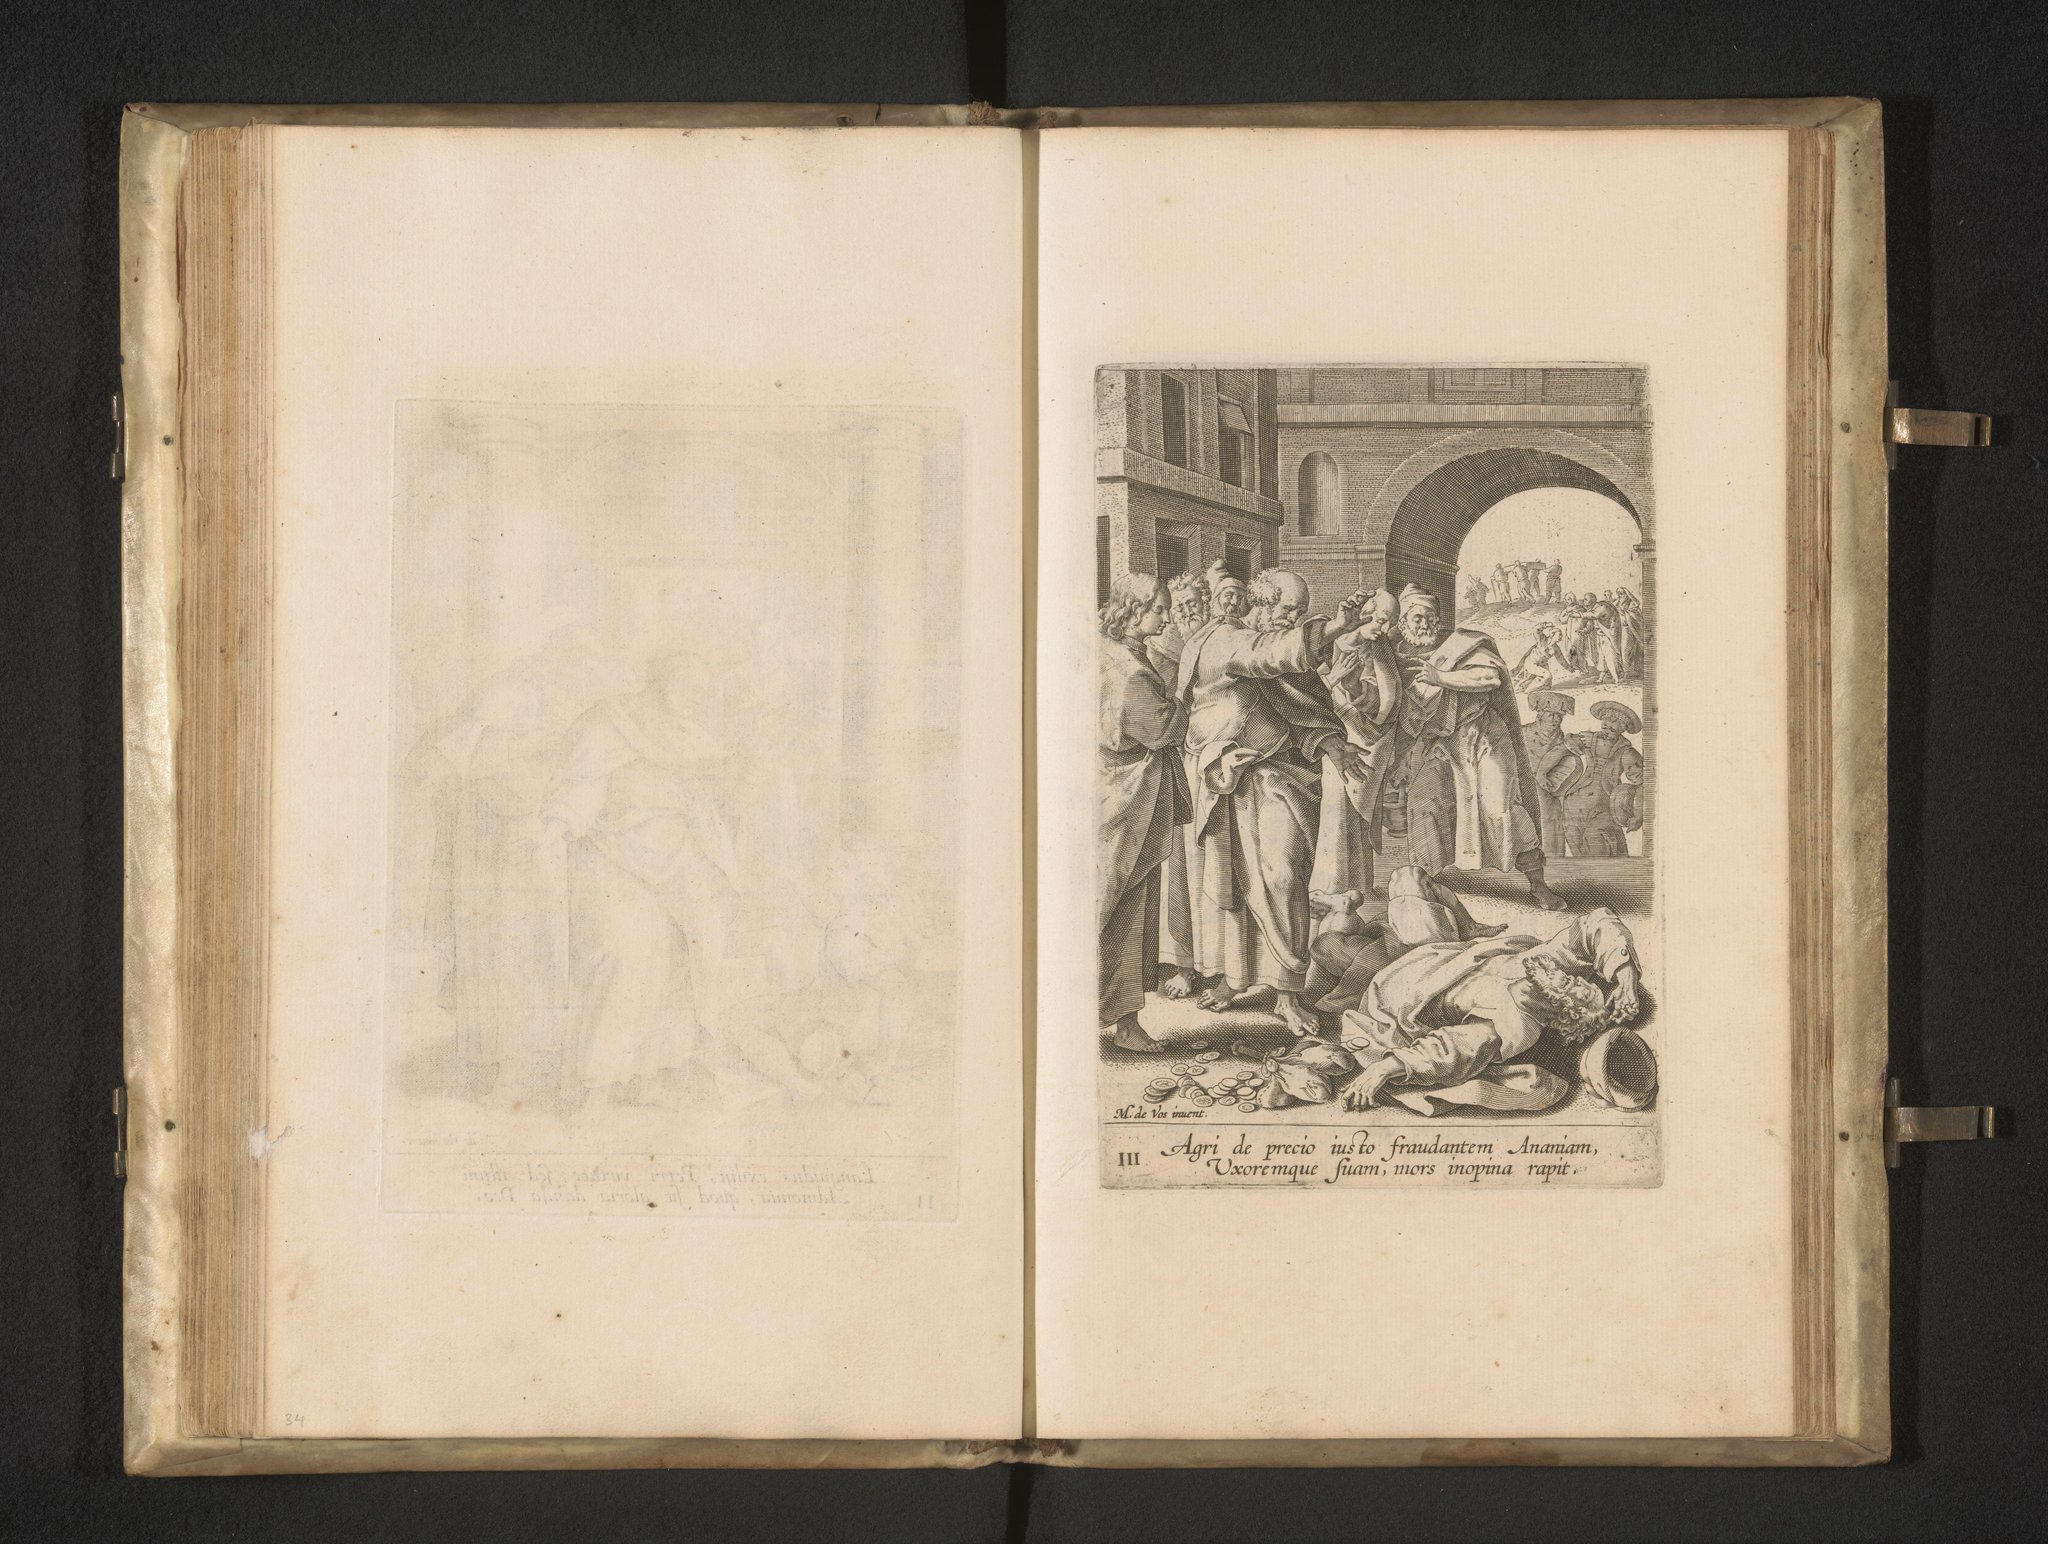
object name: print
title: Handelingen van de apostelen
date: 1580-1585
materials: paper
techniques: engraving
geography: amsterdam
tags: ananias, rebuked by peter, falls down and dies between his gifts, peter questioning sapphira, who then dies too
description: Dood van Ananias en Saffira. Linksonder genummerd: III. Onderaan in de marge een tweeregelig onderschrift in het Latijn. Onderdeel van een serie van twaalf voorstellingen van de Handelingen van de apostelen. Onderdeel van een album met voornamelijk christelijke voorstellingen.